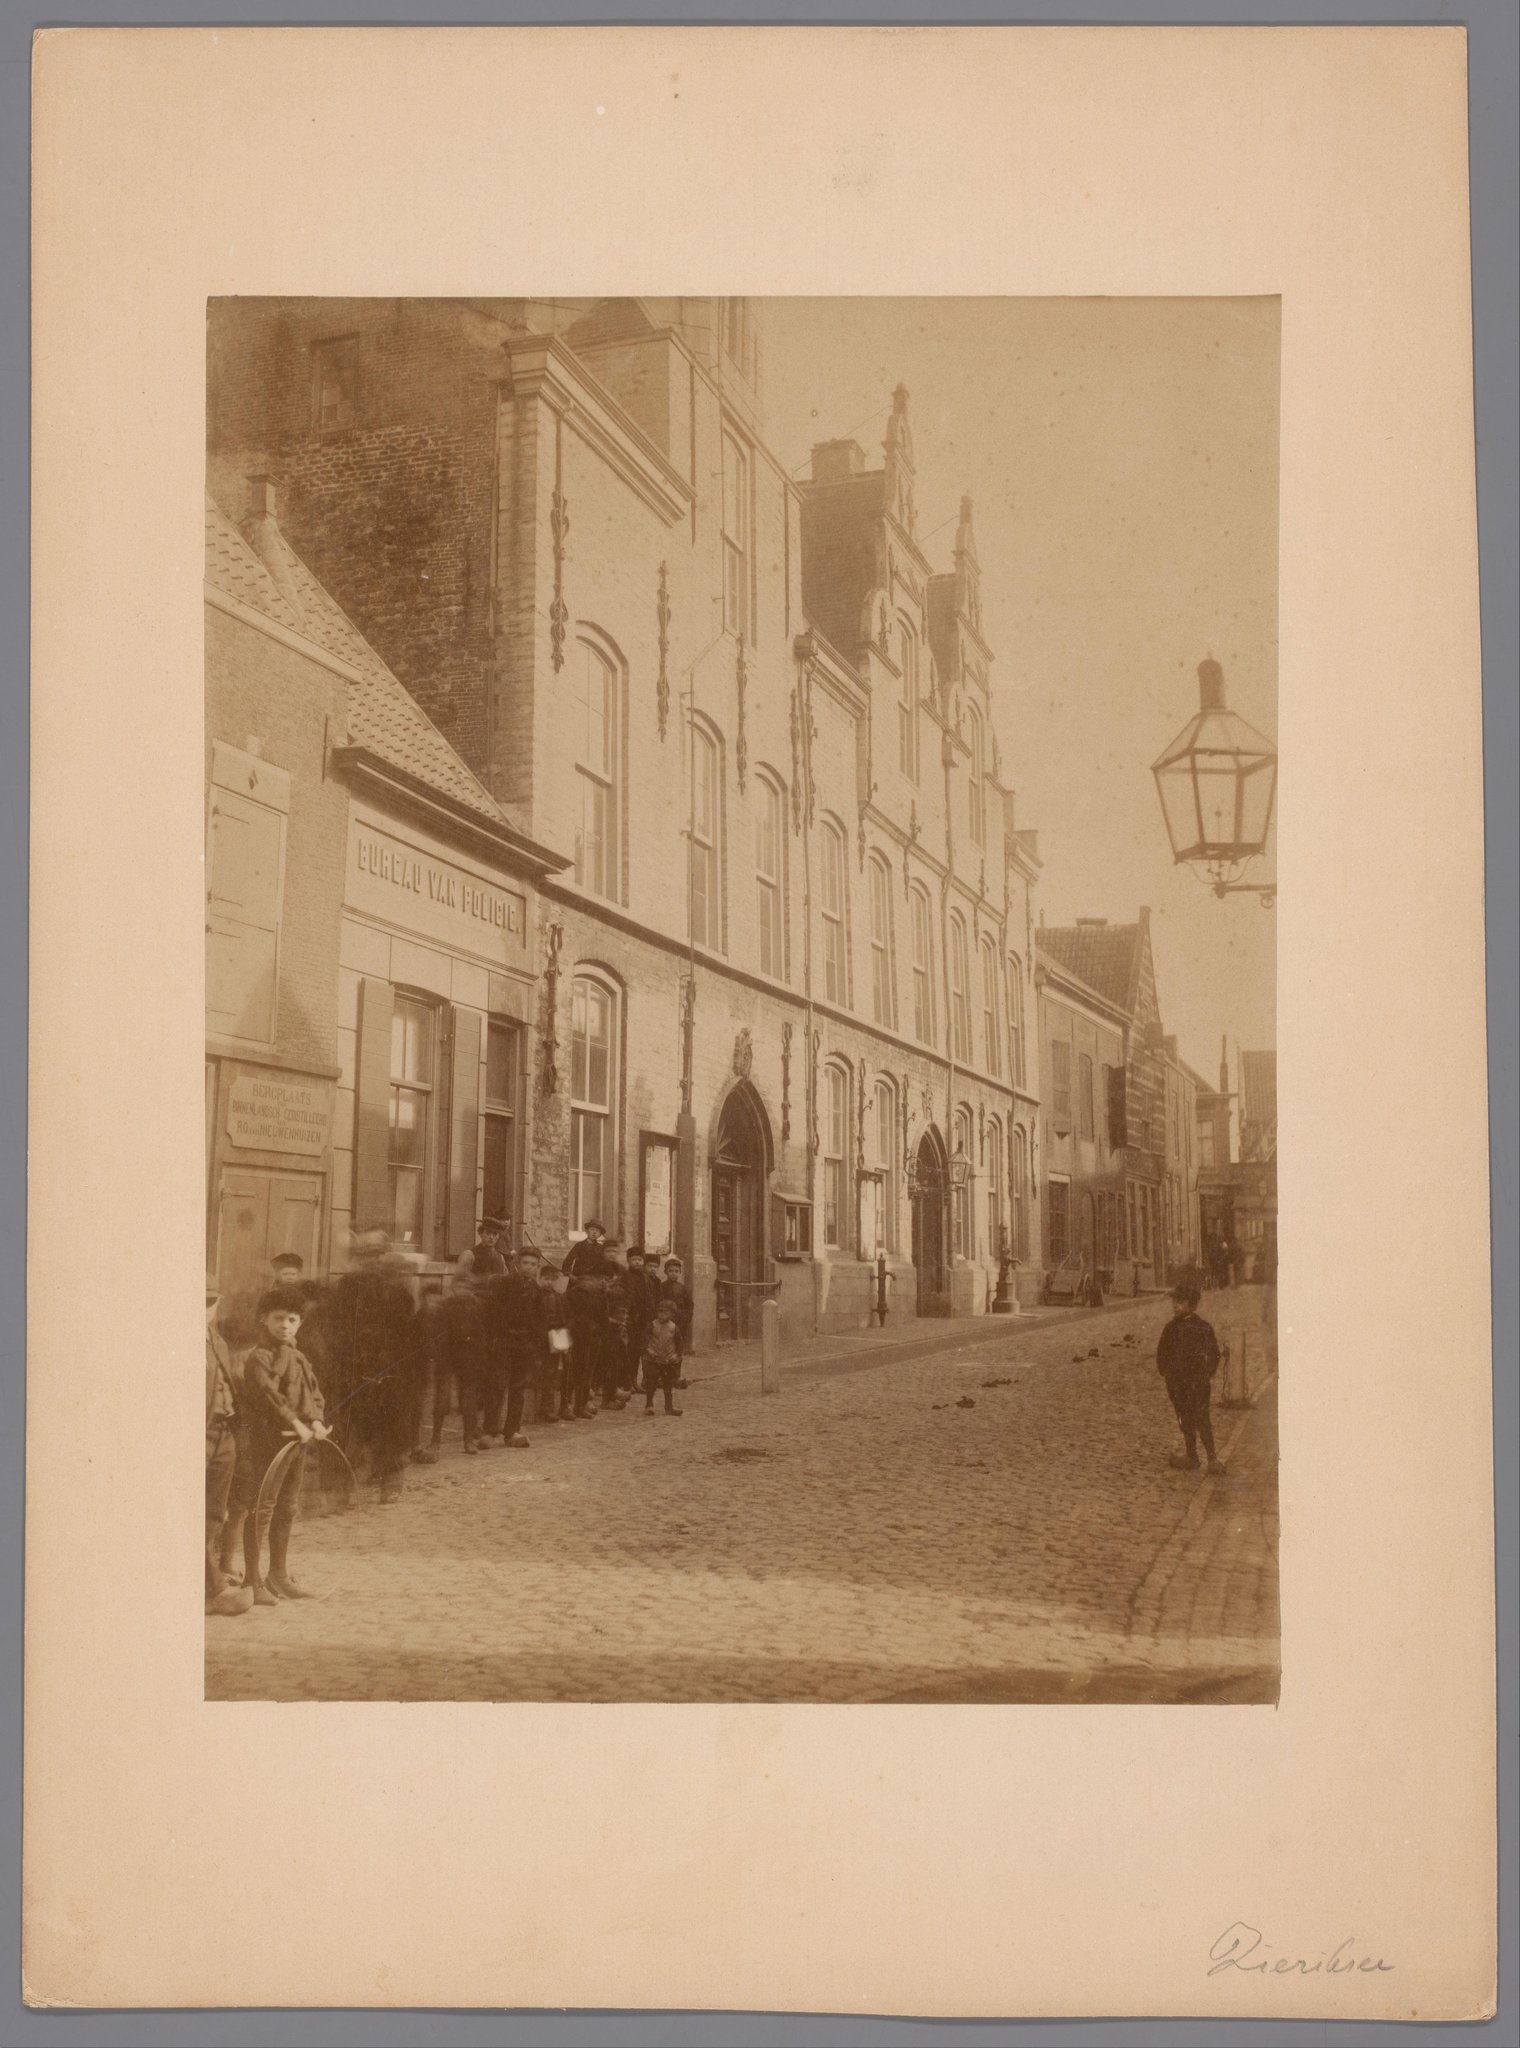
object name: photograph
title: Straatgezicht met het stadhuis van Zierikzee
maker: anoniem (monumentenzorg)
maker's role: fotograaf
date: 1893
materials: cardboard, photographic support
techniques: albumen print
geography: zierikzee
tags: townhall, street (+ city(-scape) with figures, staffage)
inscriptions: annotation: ‘Zierikzee’, annotation: ‘Zierikzee (Z)/ Raadhuis in de Meelstraat/ Maart 1893’